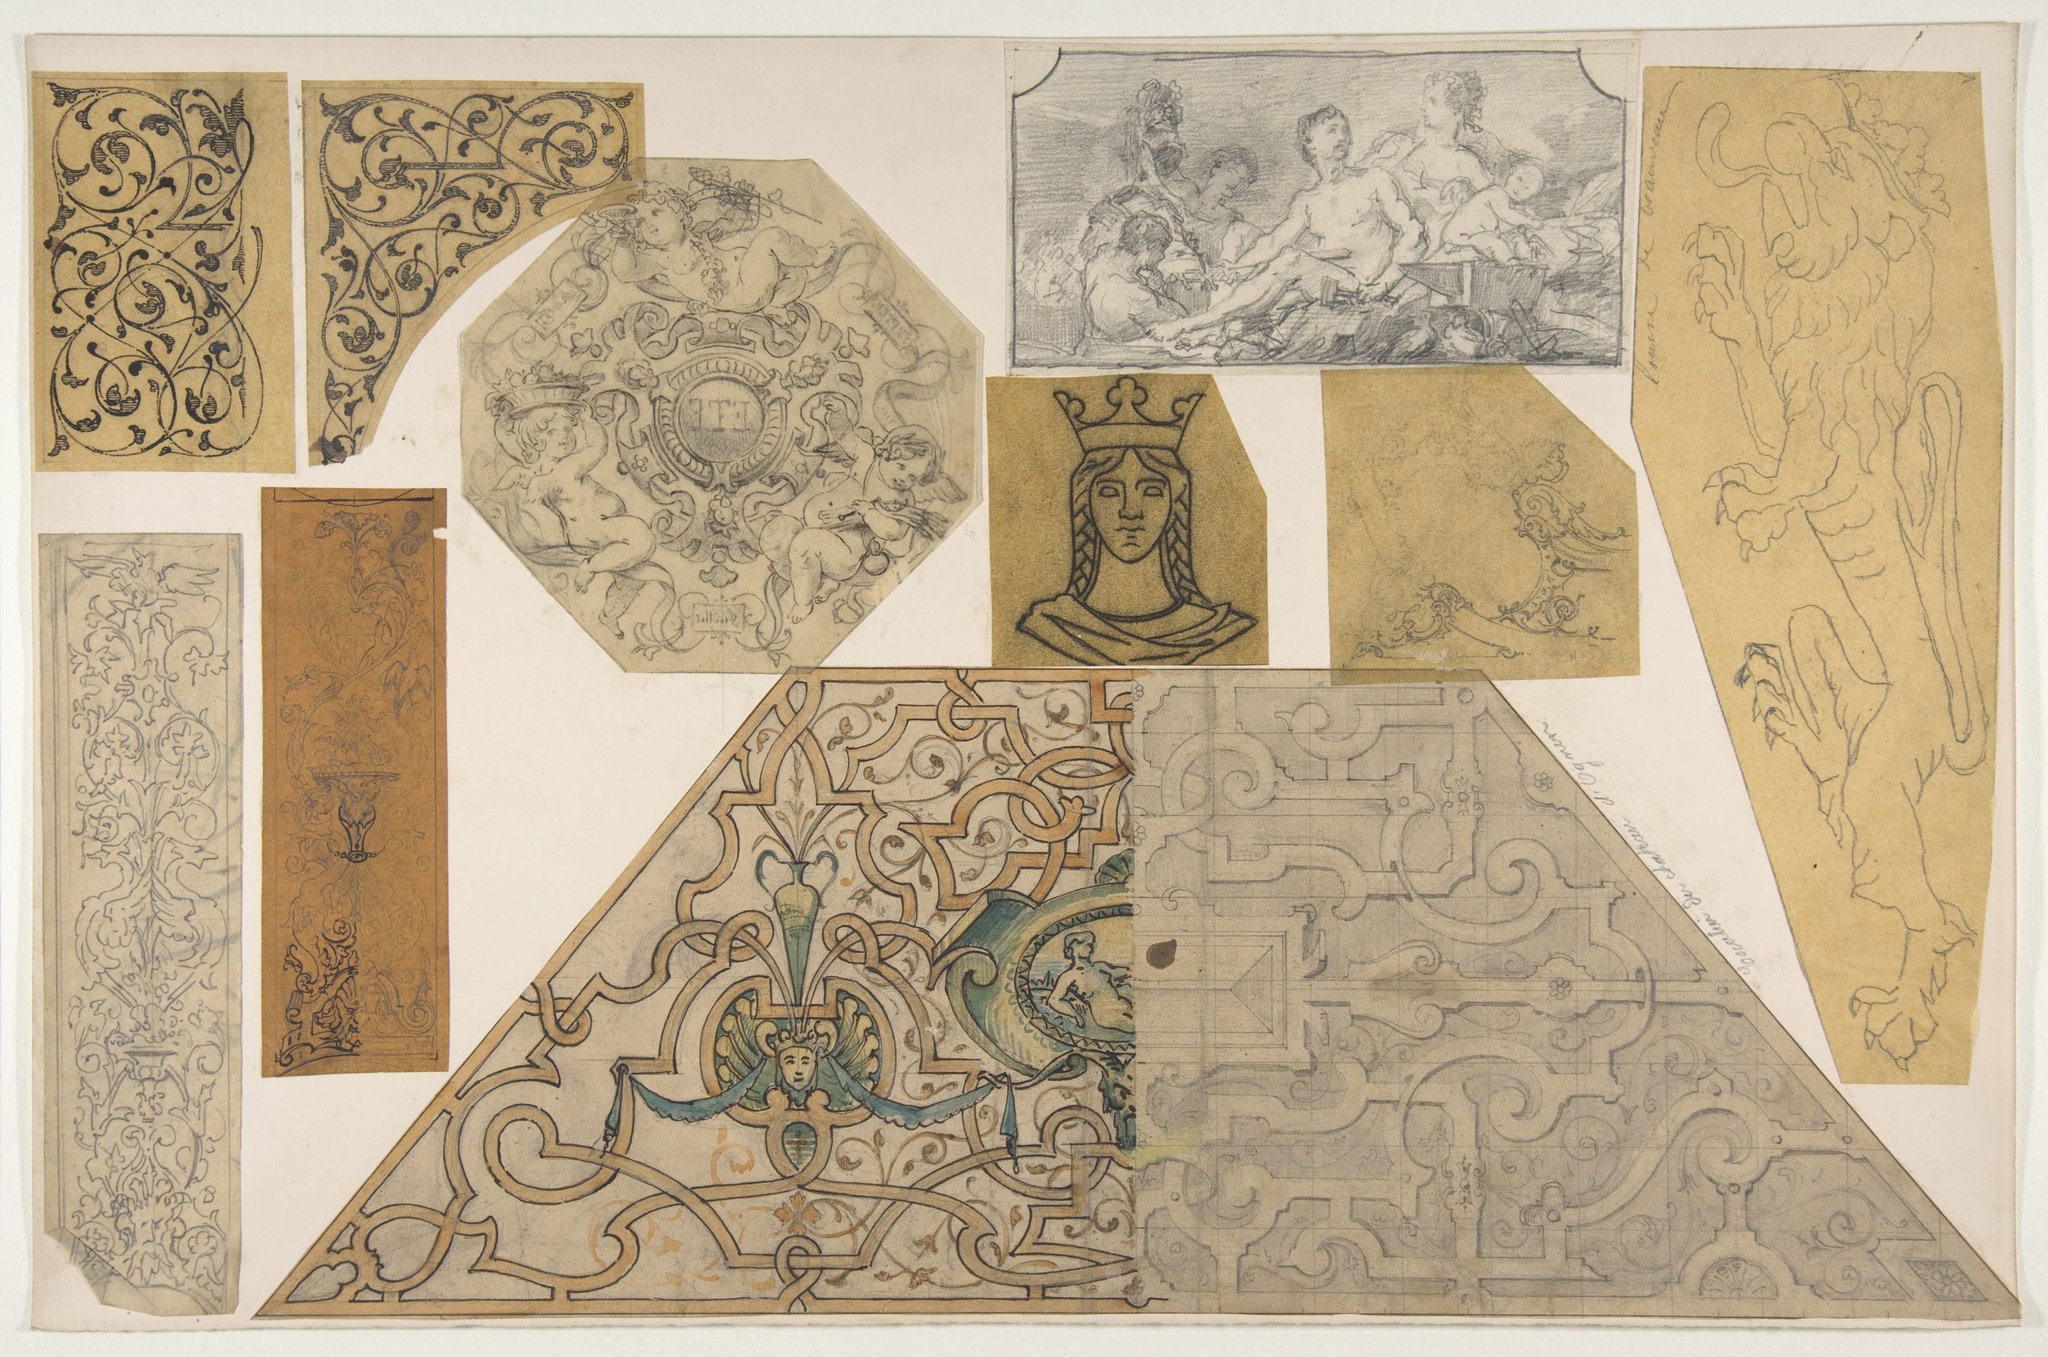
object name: drawing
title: Ten designs for the decoration of houses, including at least one for the stairway of the Chateau d'Ognon of M. deMachy (Oise, France)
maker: jules-edmond-charles lachaise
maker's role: artist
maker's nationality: french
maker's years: 1897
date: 1851-1900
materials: cardboard, graphite, ink, paper, watercolor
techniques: pen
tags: human figures,ornament,lions,coat of arms